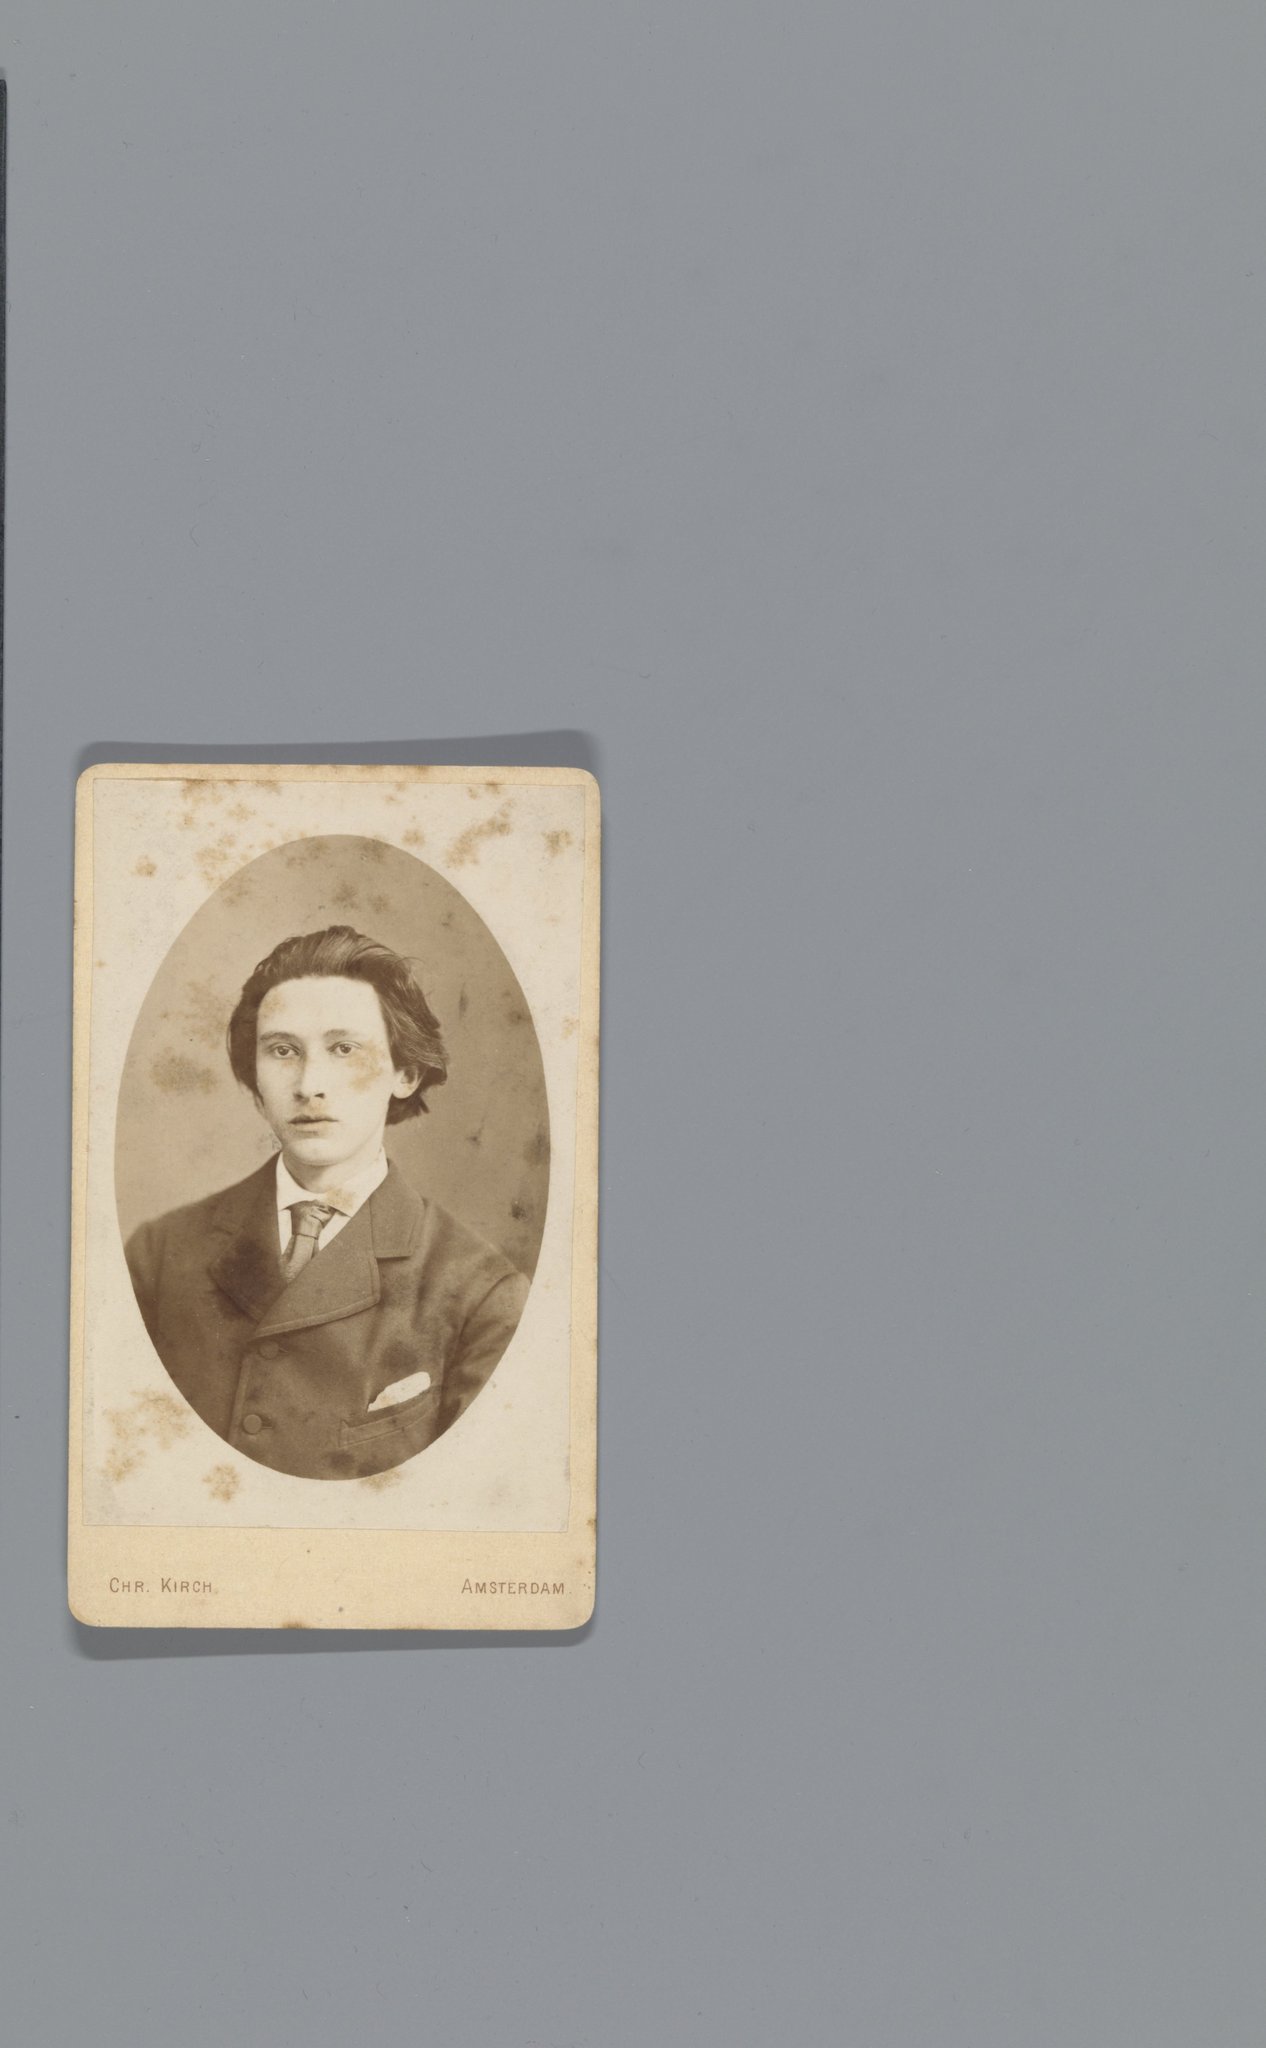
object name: carte de visite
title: Karel Witsen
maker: christian theodor kirch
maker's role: fotograaf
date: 1860-1915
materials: cardboard, paper, photographic support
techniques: albumen print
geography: netherlands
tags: karel witsen